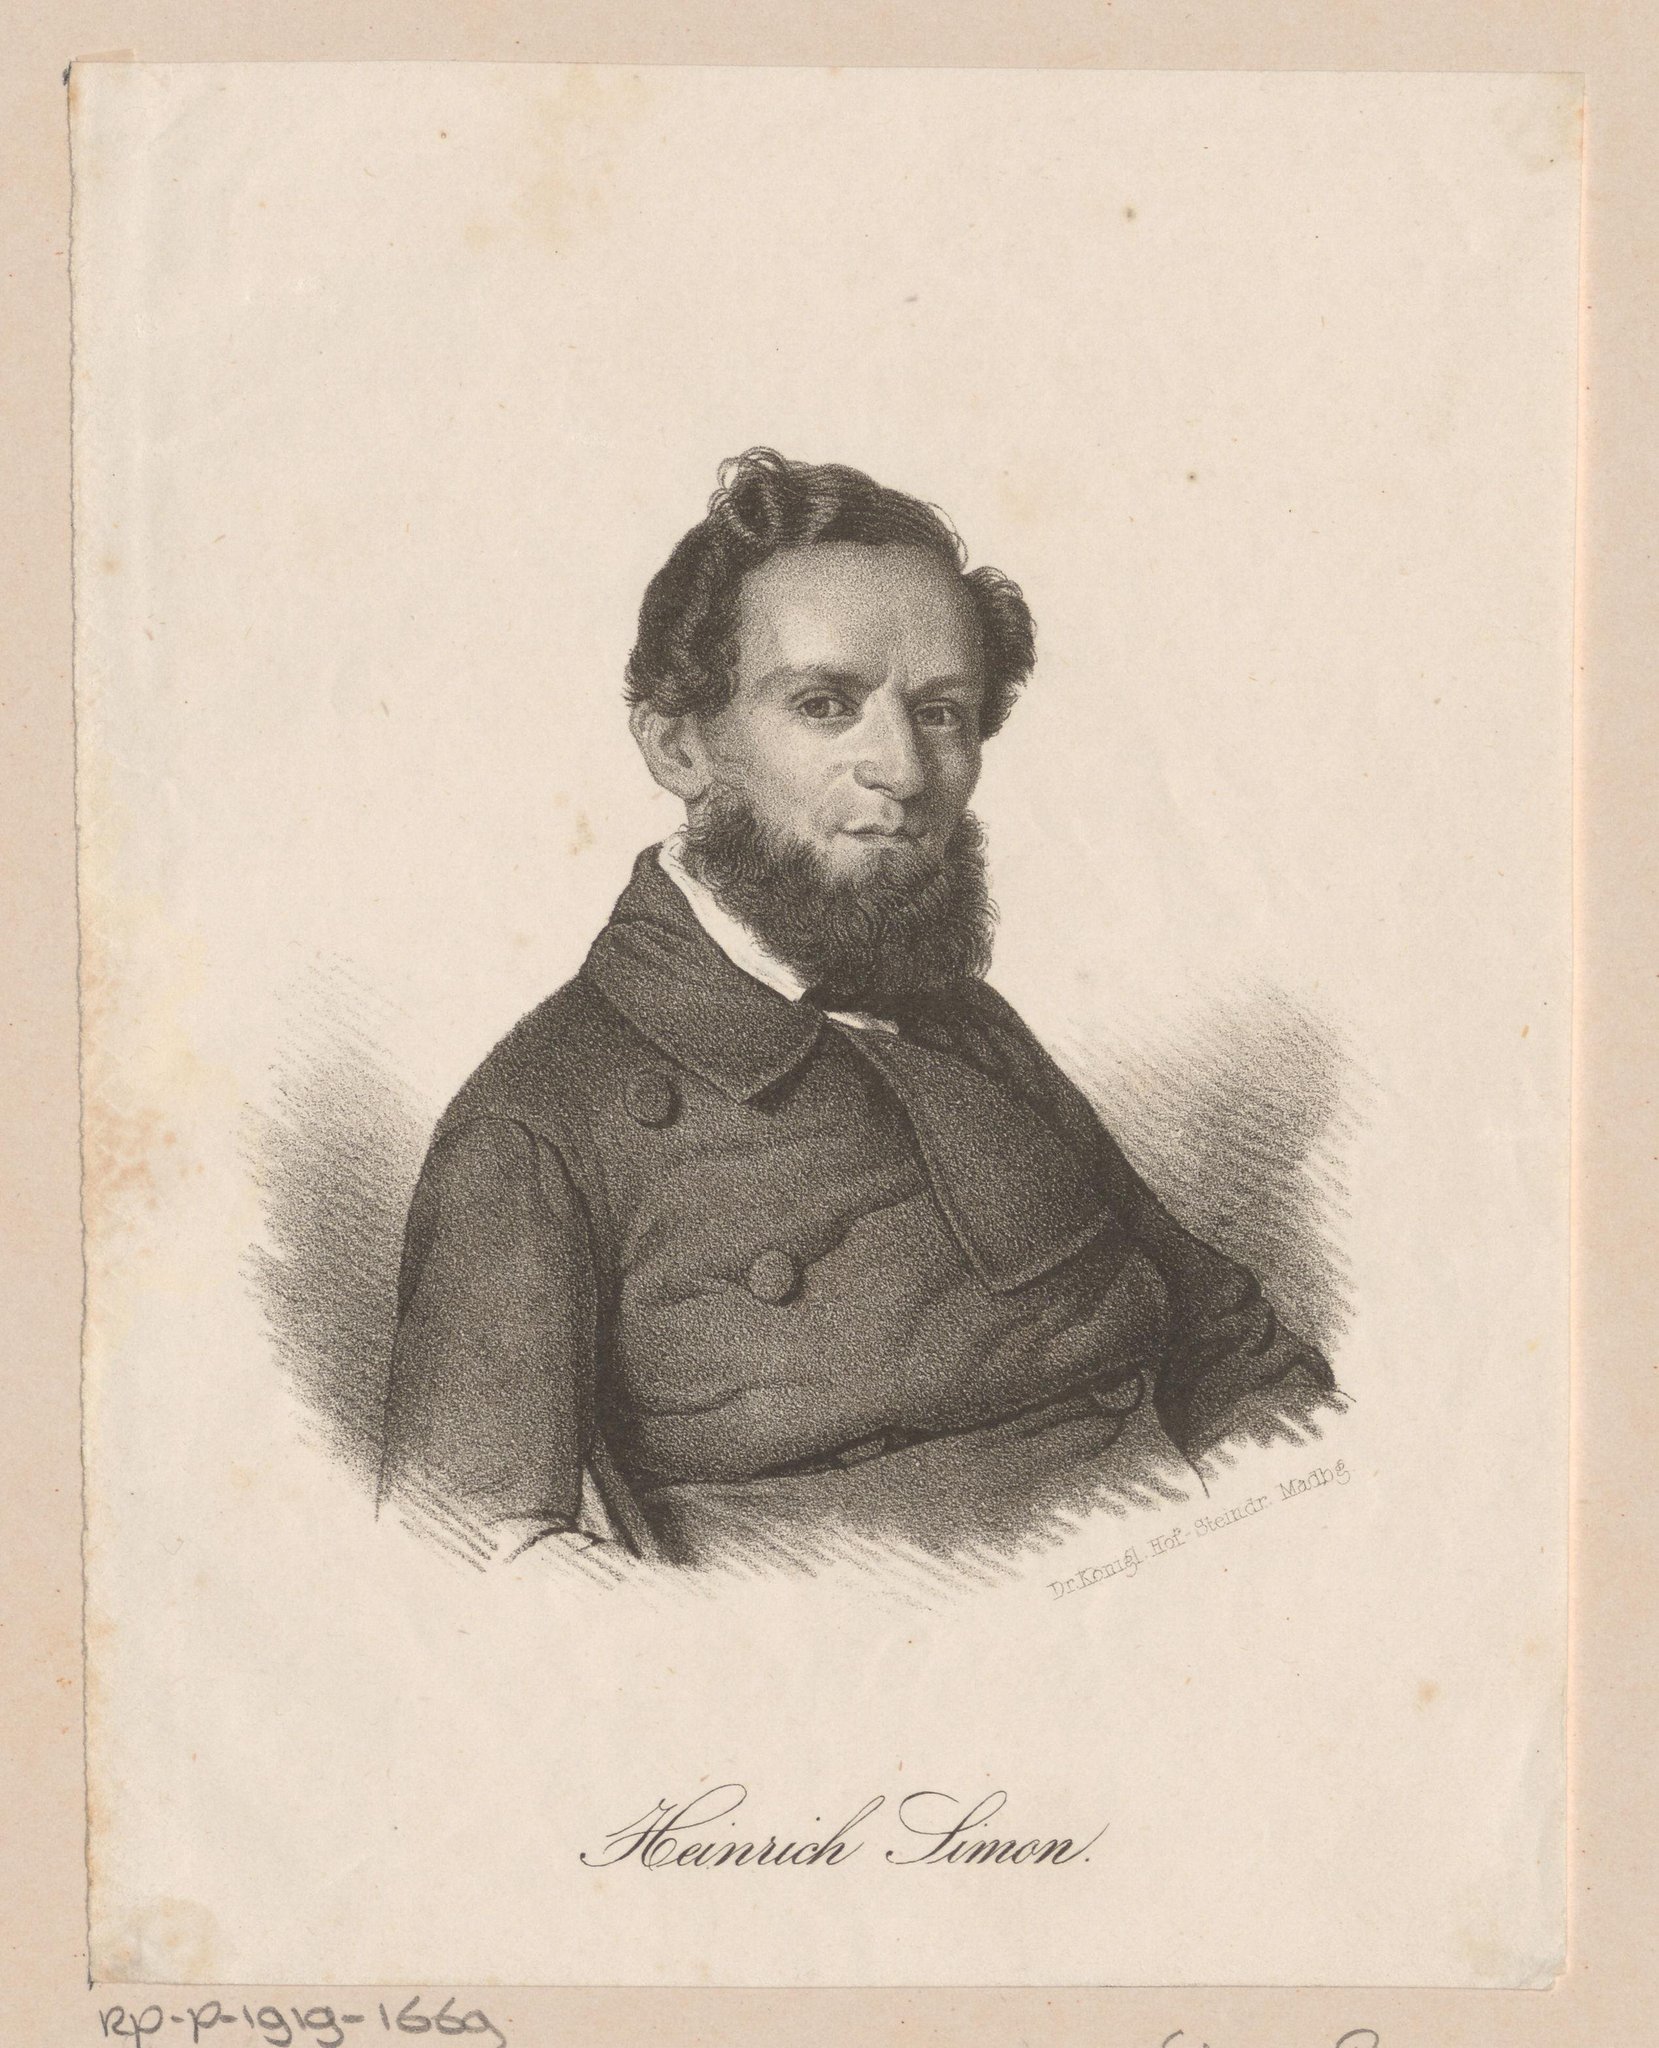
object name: print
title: Portret van Heinrich Simon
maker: Anonymous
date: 1835-1899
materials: paper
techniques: lithograph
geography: magdeburg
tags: historical persons, politician, e.g. party leader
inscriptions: collector's mark: Lugt 2228